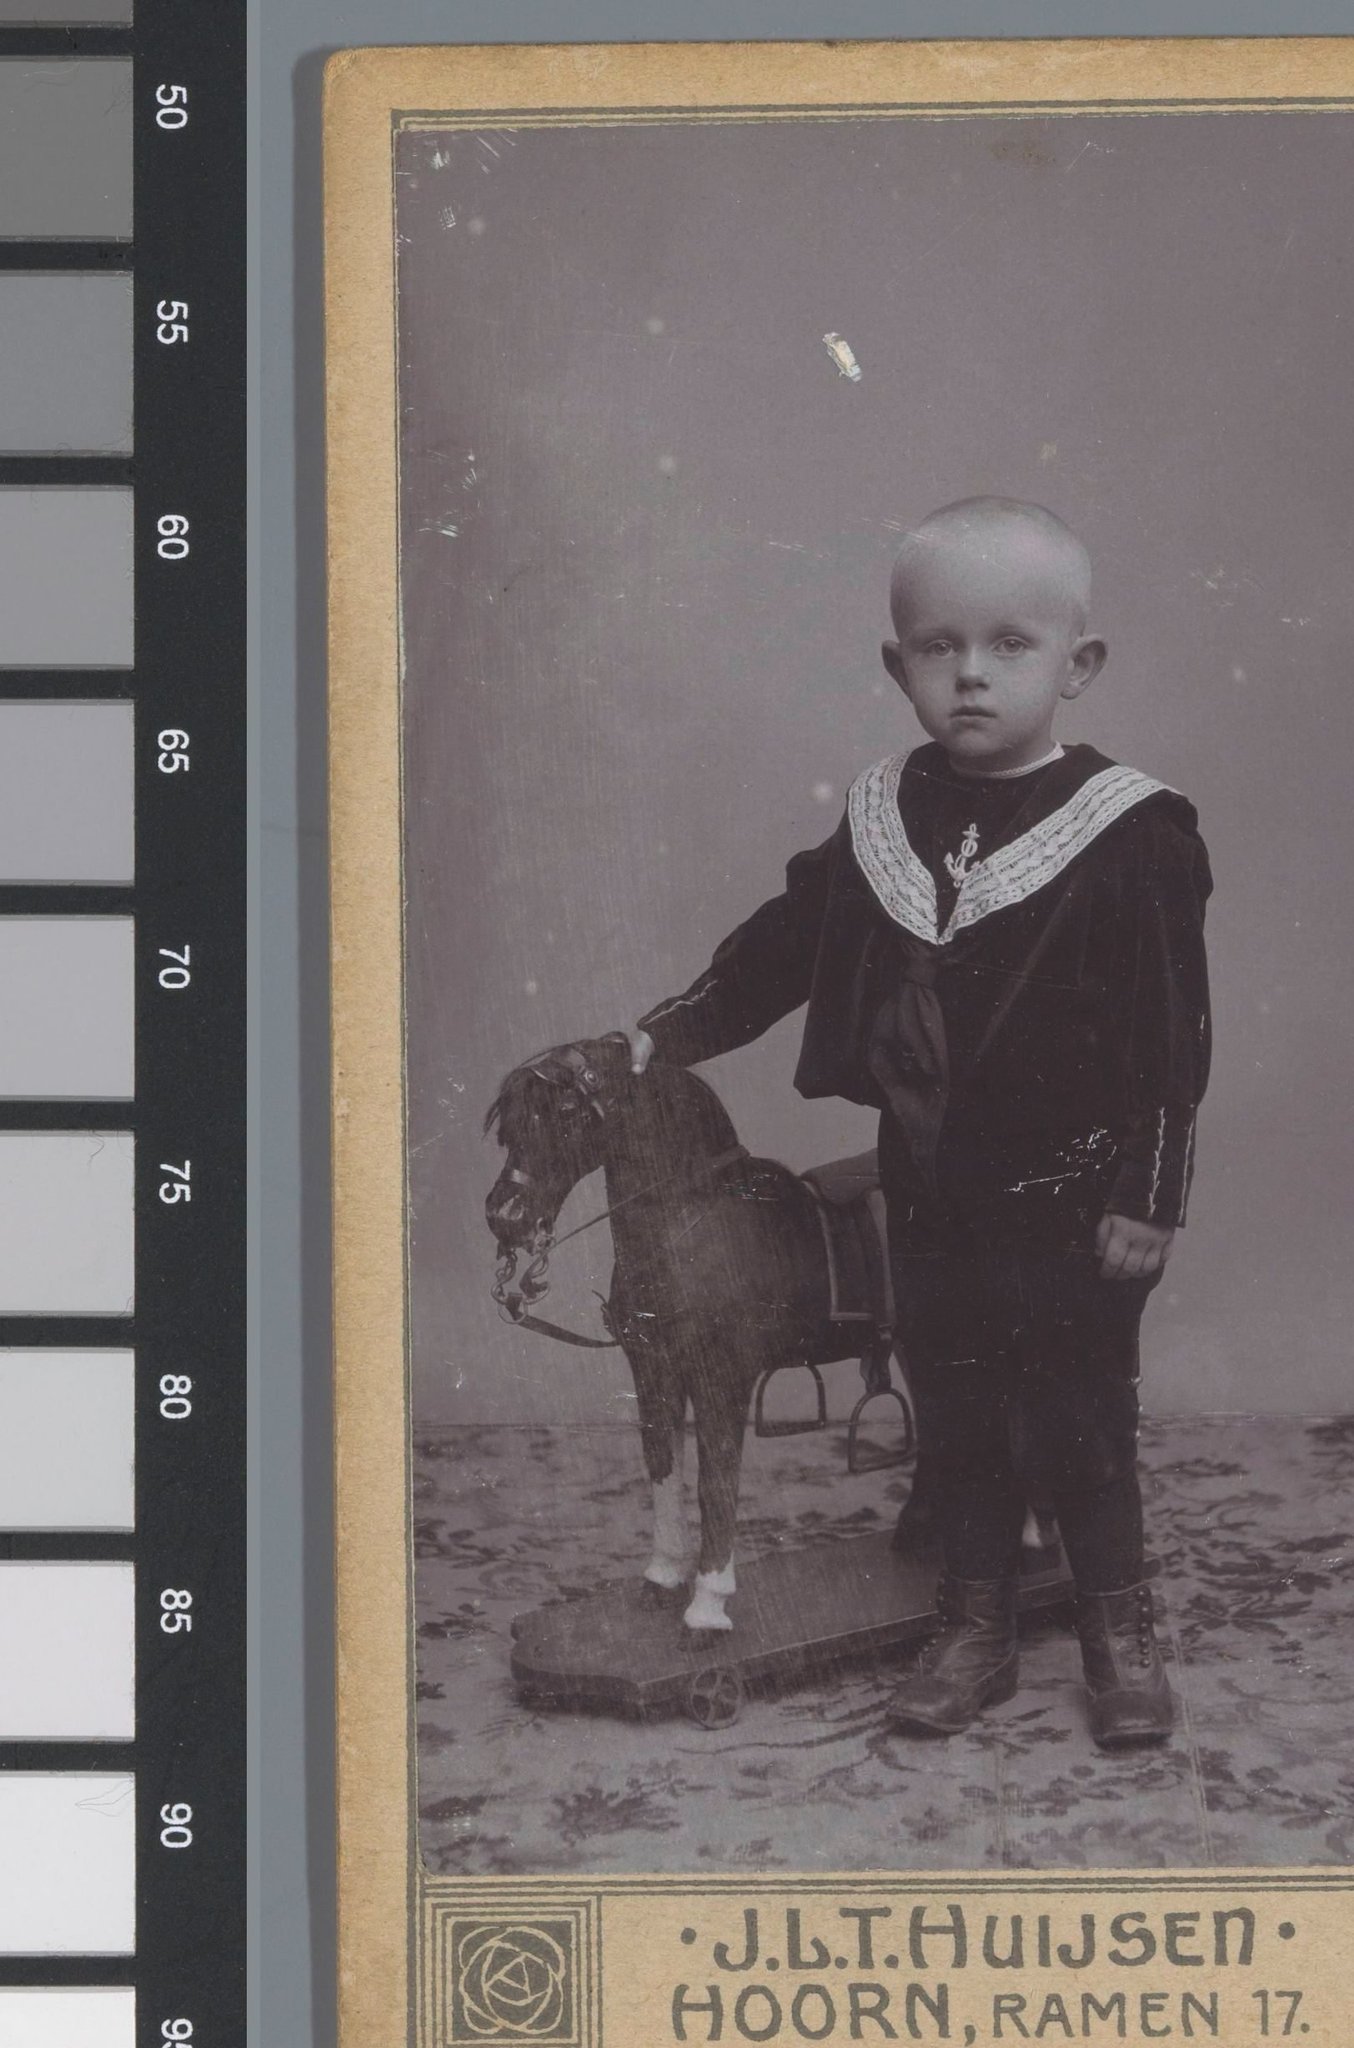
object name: photograph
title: Portret van Almer Middelbeek naast een speelgoedpaard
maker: johannes laurens theodorus huijsen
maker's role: fotograaf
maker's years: 1852-1910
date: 1883-1915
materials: cardboard, photographic support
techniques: collodion silver print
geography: hoorn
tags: boy (child between toddler and youth), hobby-horse, historical persons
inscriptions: inscription: ‘D. Middel/beek’, inscription: ‘J. L. T. HUIJSEN/ PHOTOGRAPHE/ Bekroond/ op verschillende Tentoonstellingen/ HOORN/ Ramen 17./ De plaat blijft ter/ nabestelling bewaard.’